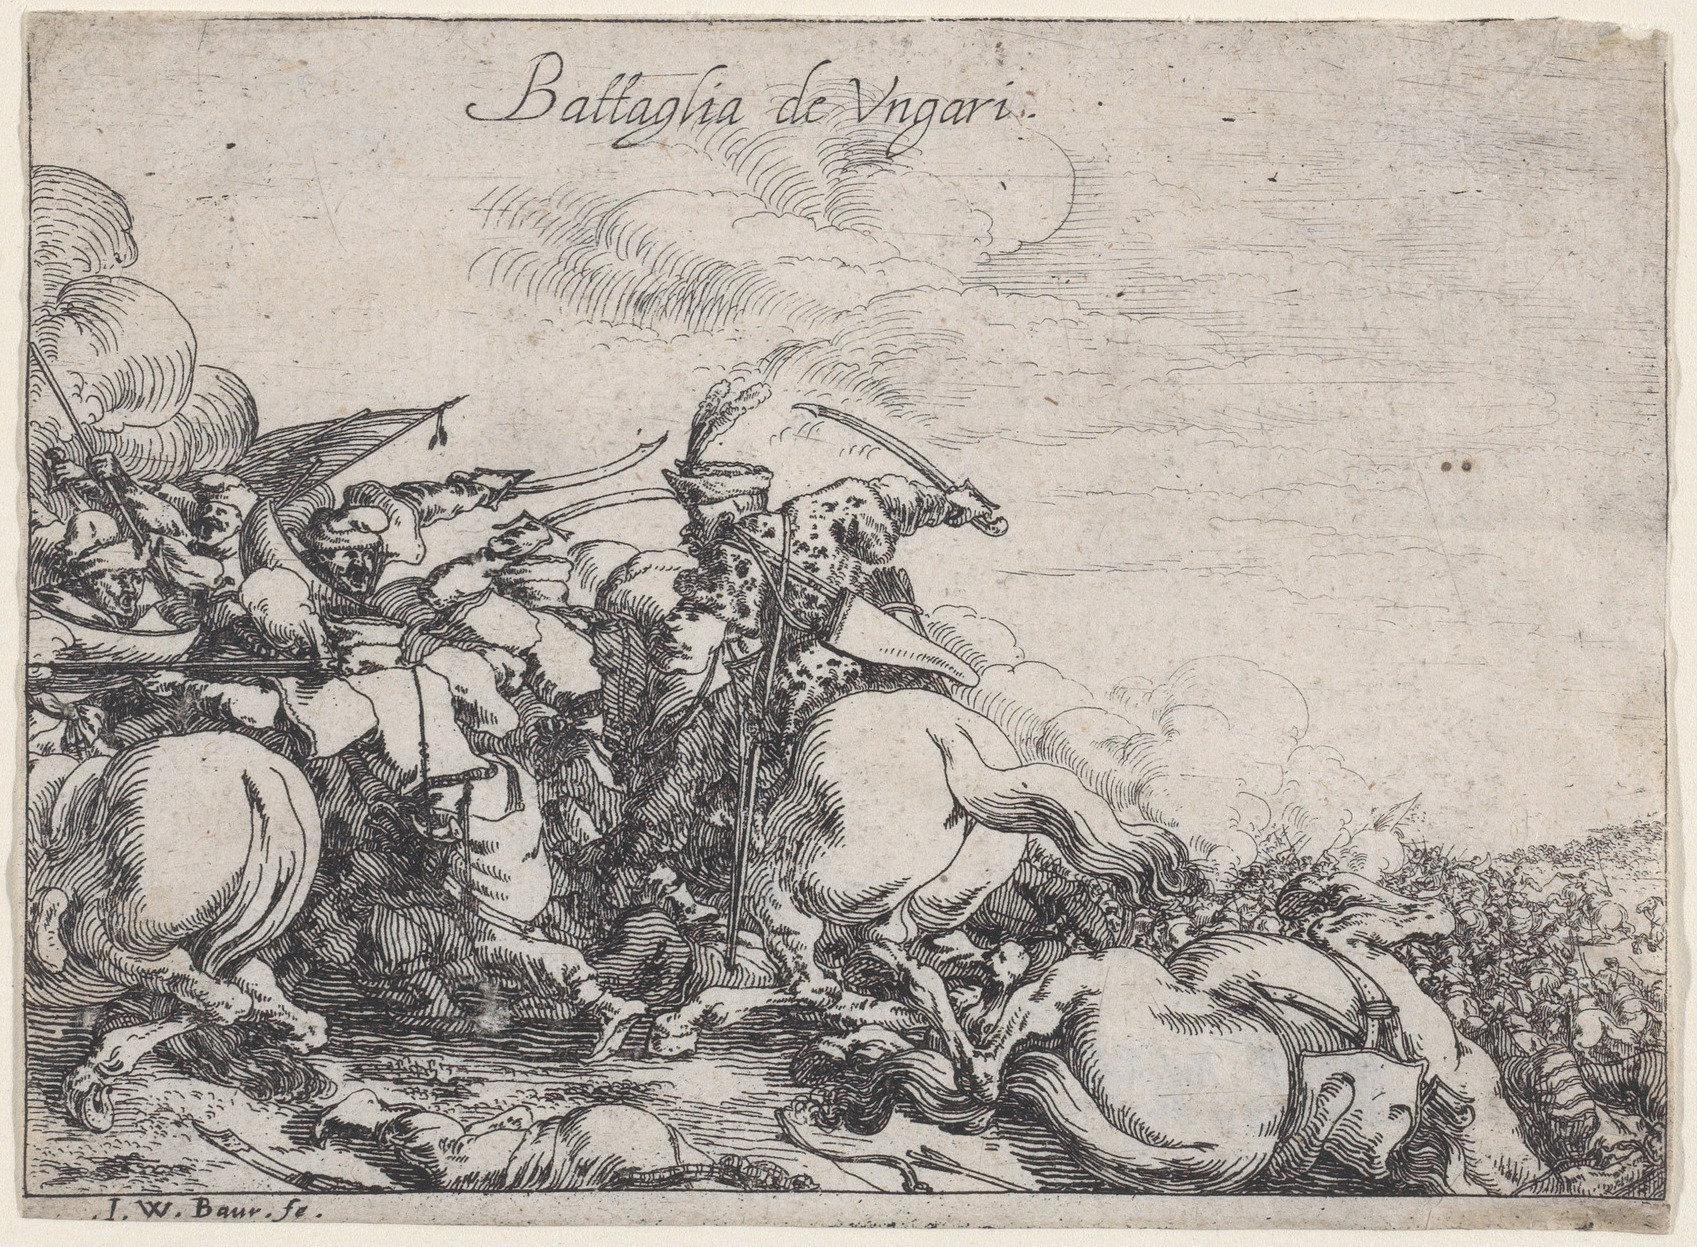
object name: print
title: Battaglia de Ungari, from 'Battles of Different Nations' (Capricci di varie battaglie)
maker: johann wilhelm baur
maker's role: artist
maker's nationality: german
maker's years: 1607-1642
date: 1600-1640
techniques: etching